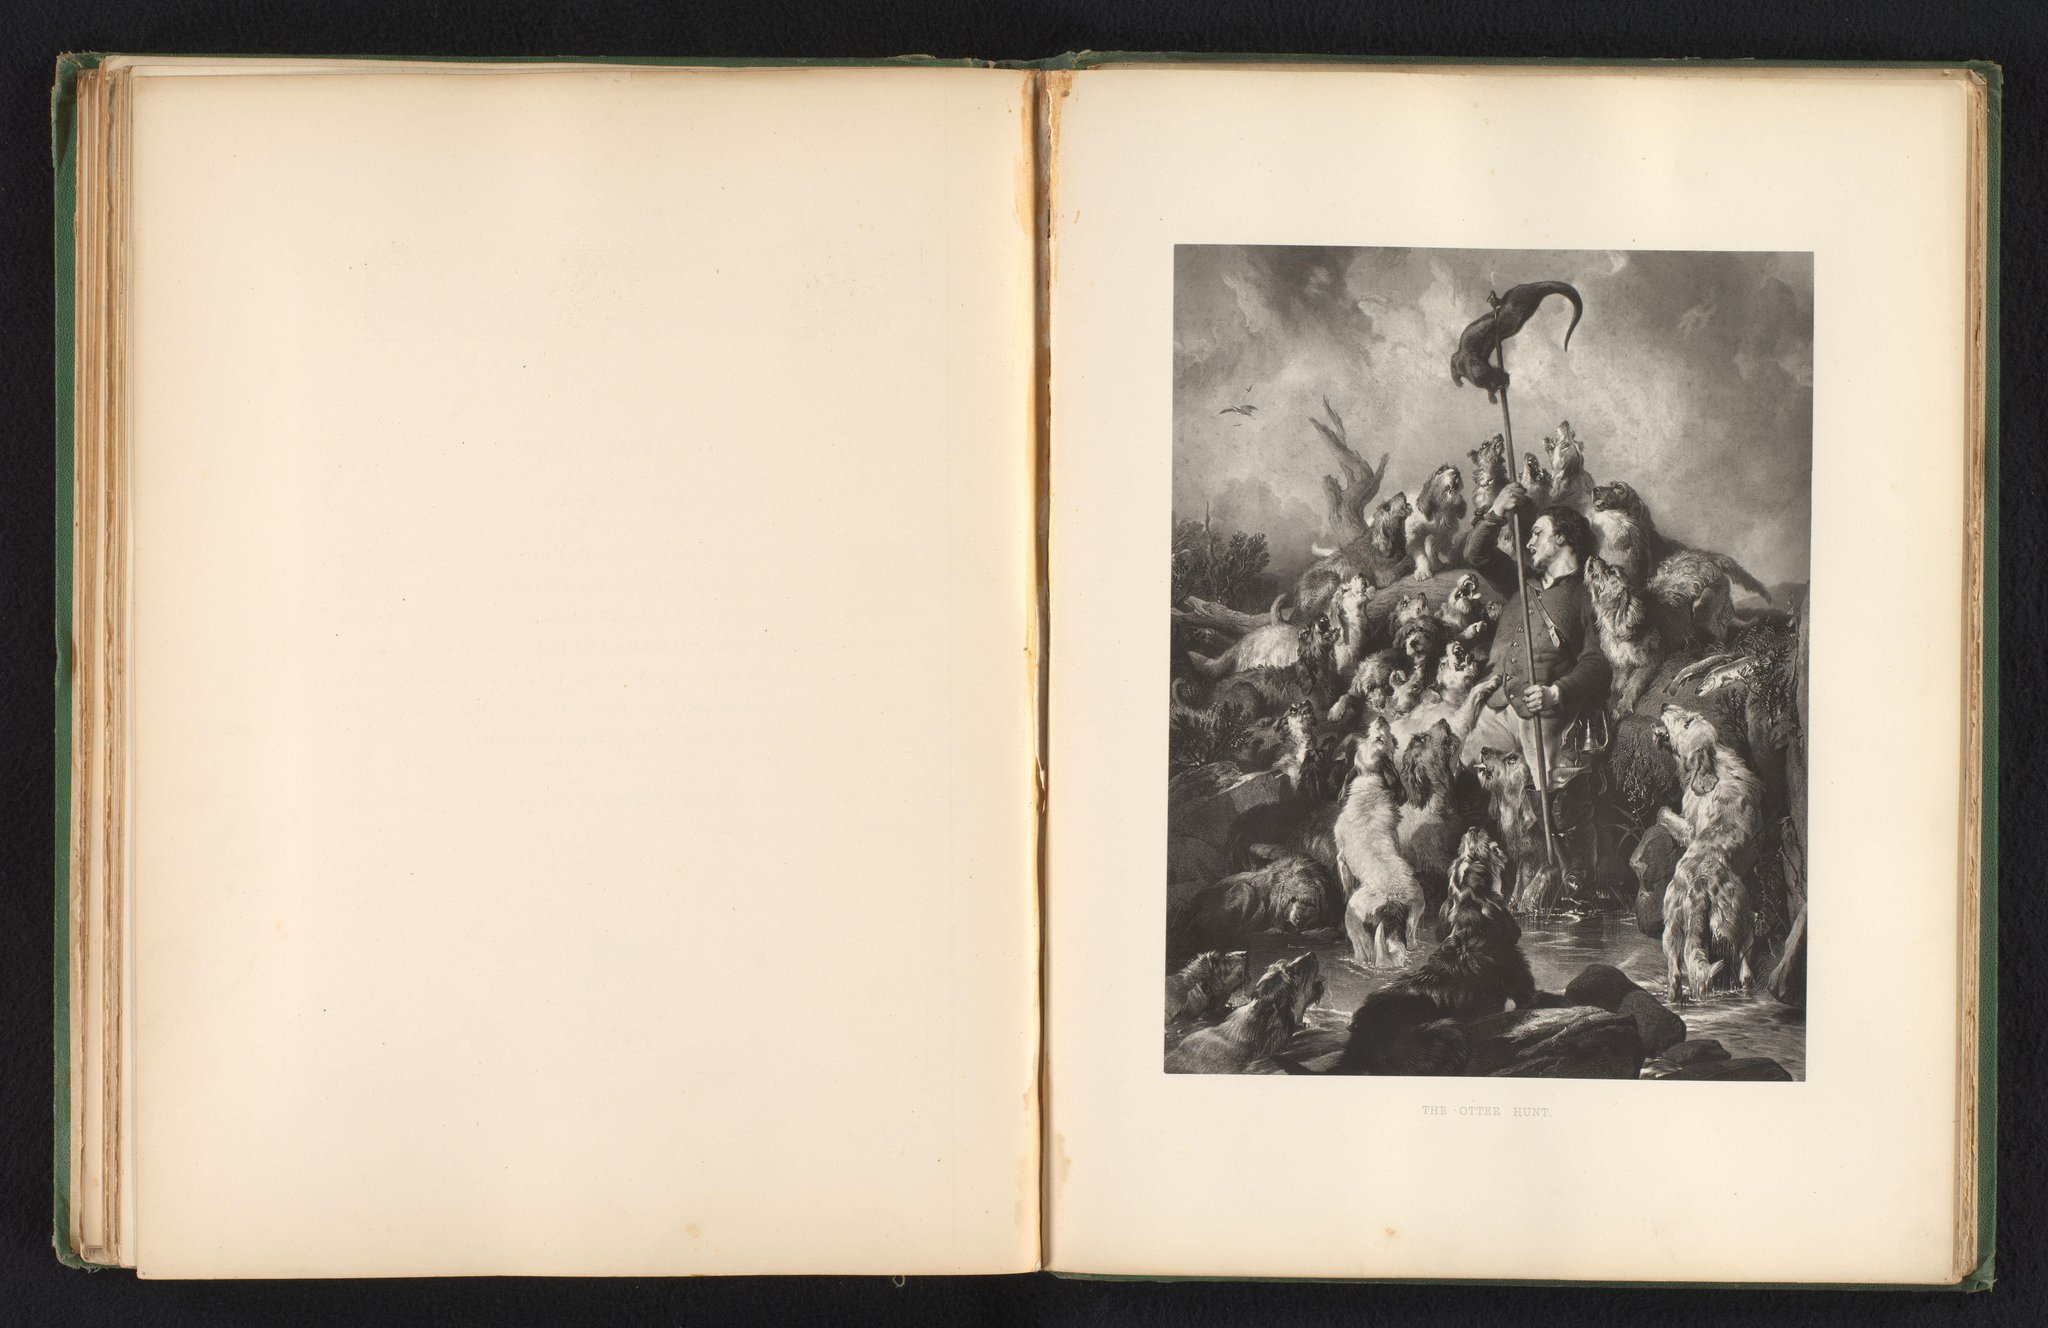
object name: photomechanical print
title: The otter hunt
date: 1878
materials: paper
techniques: woodburytype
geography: london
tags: hunter, beasts of prey, predatory animals: otter, dog